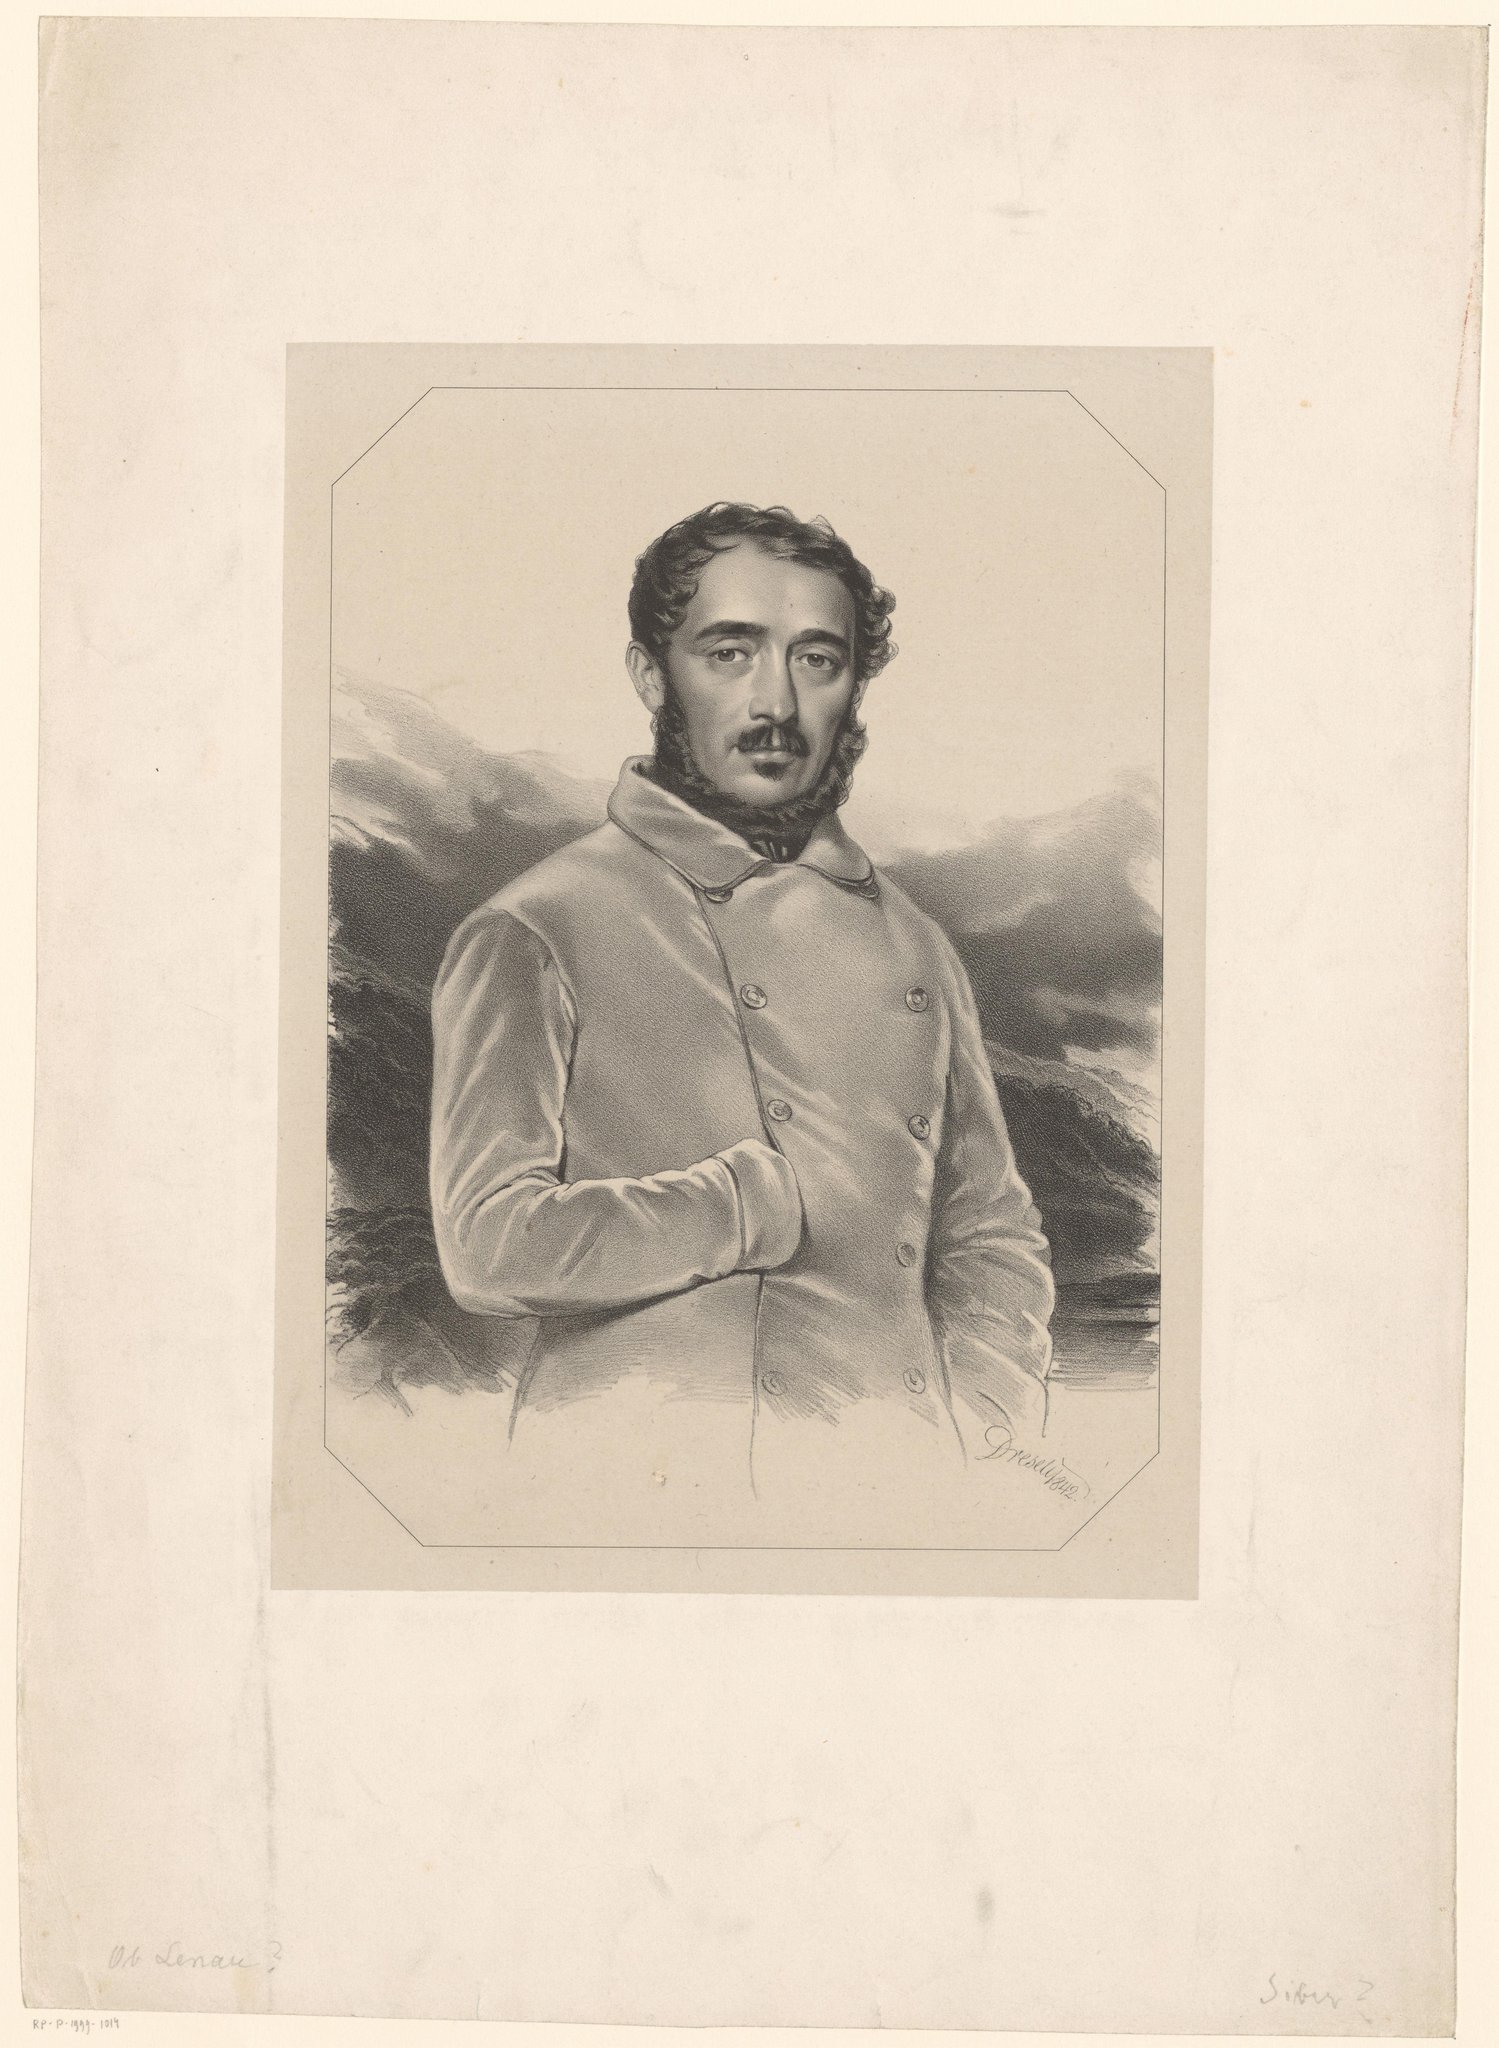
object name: print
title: Portret van een onbekende man, mogelijk Nikolaus Lenau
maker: johann baptist dresely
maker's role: draughtsman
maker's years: 1787-1864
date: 1842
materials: paper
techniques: lithograph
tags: adult man, historical persons, beard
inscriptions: collector's mark: Lugt 2228, collector's mark: Lugt 2760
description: Naar rechts, een hand in de jas voor de borst. Mogelijk de Oostenrijkse dichter Nilokaus Lenau (1802-1850).